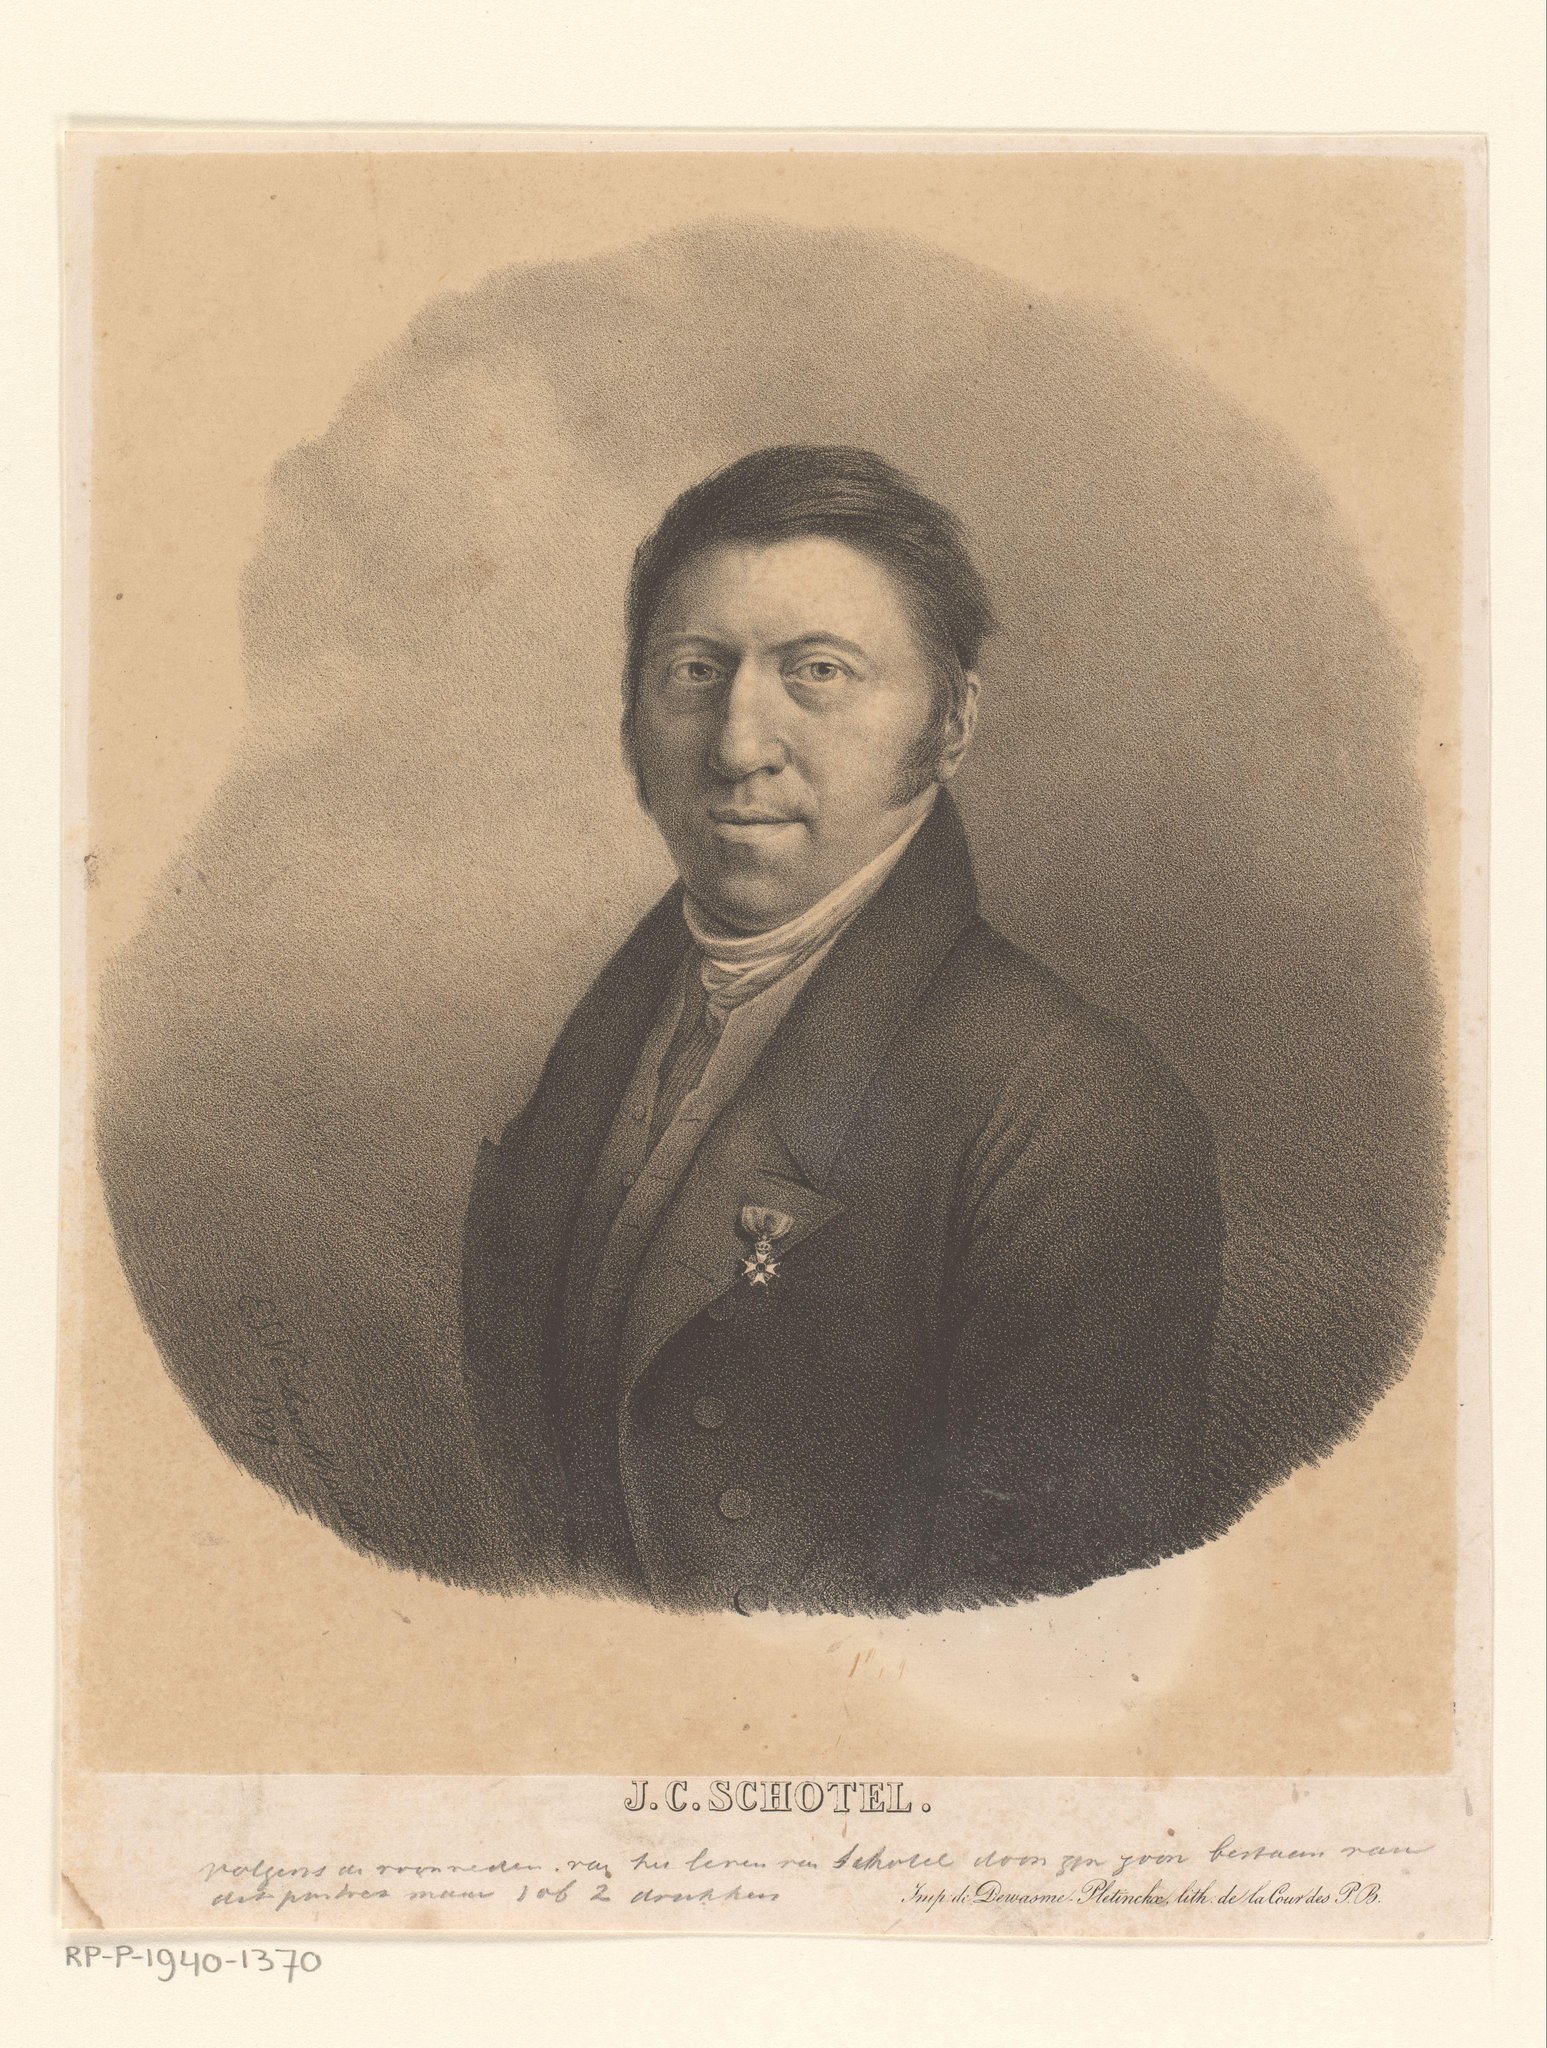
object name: print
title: J.C. Schotel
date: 1827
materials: paper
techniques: lithograph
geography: brussels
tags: dordrecht, painter, print maker, draughtsman, johannes christiaan schotel, historical persons, portrait, self-portrait of painter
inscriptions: annotation: ‘Volgens de [voorreden] van het leven van Schotel door zijn zoon bestaan van/ dit portret maar 1 of 2 drukken’, collector's mark: Lugt 2228, collector's mark: Lugt 2760